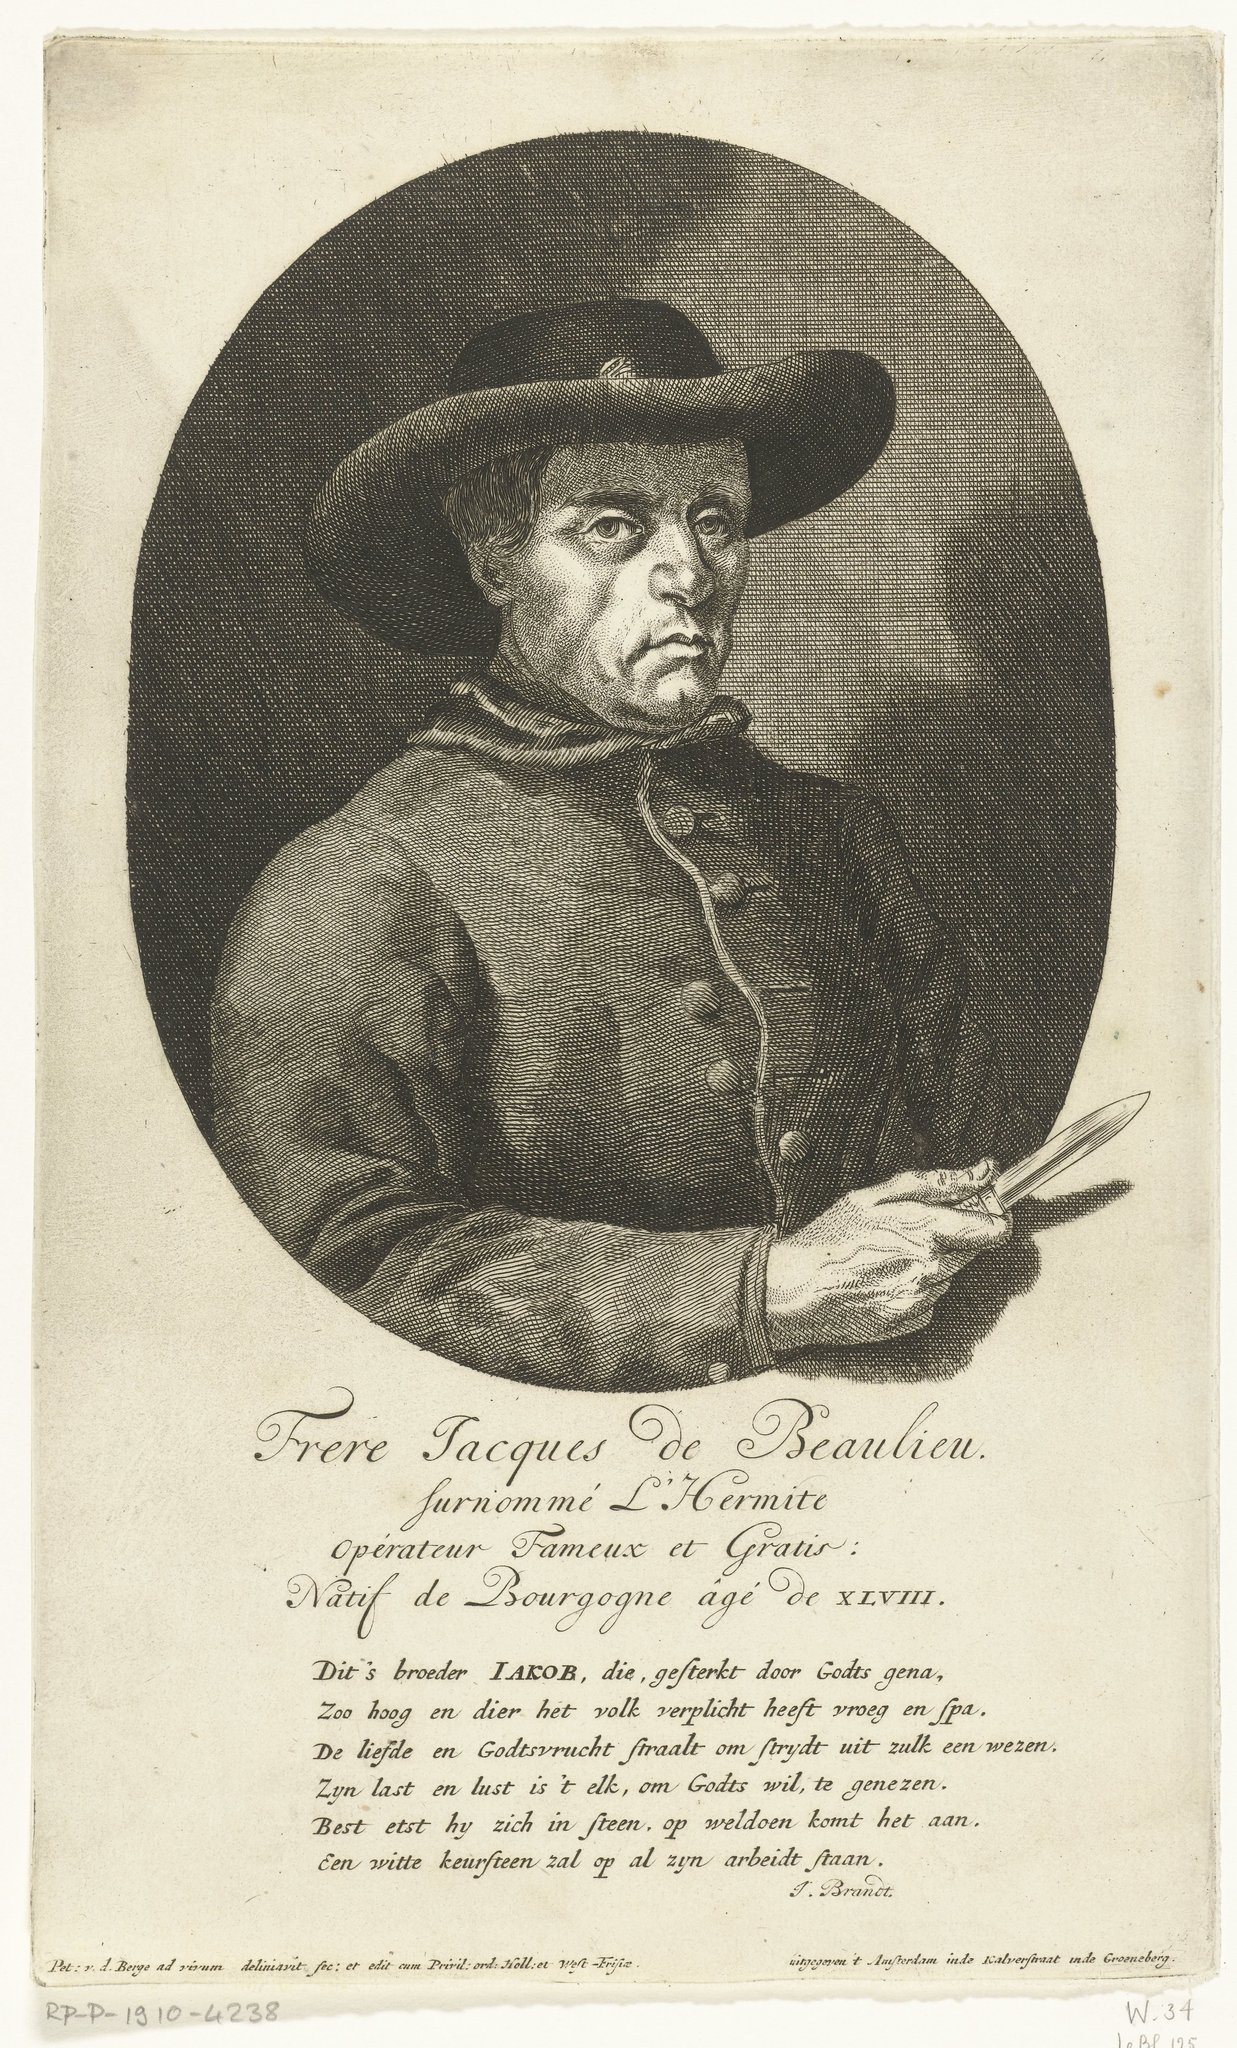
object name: print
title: Portret van frère Jaques de Beaulieu op 48-jarige leeftijd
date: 1699-1737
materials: paper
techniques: engraving, etching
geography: amsterdam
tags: france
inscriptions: collector's mark: Lugt 2228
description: Borstbeeld van frère Jaques de Beaulieu die tijdens twee bezoeken aan Amsterdam een aantal blaassteenoperaties verrichte. Hij is afgebeeld met een mes in zijn hand. Onder het portret een vers in het Nederlands op De Beaulieu's werk door Johannes Brandt.